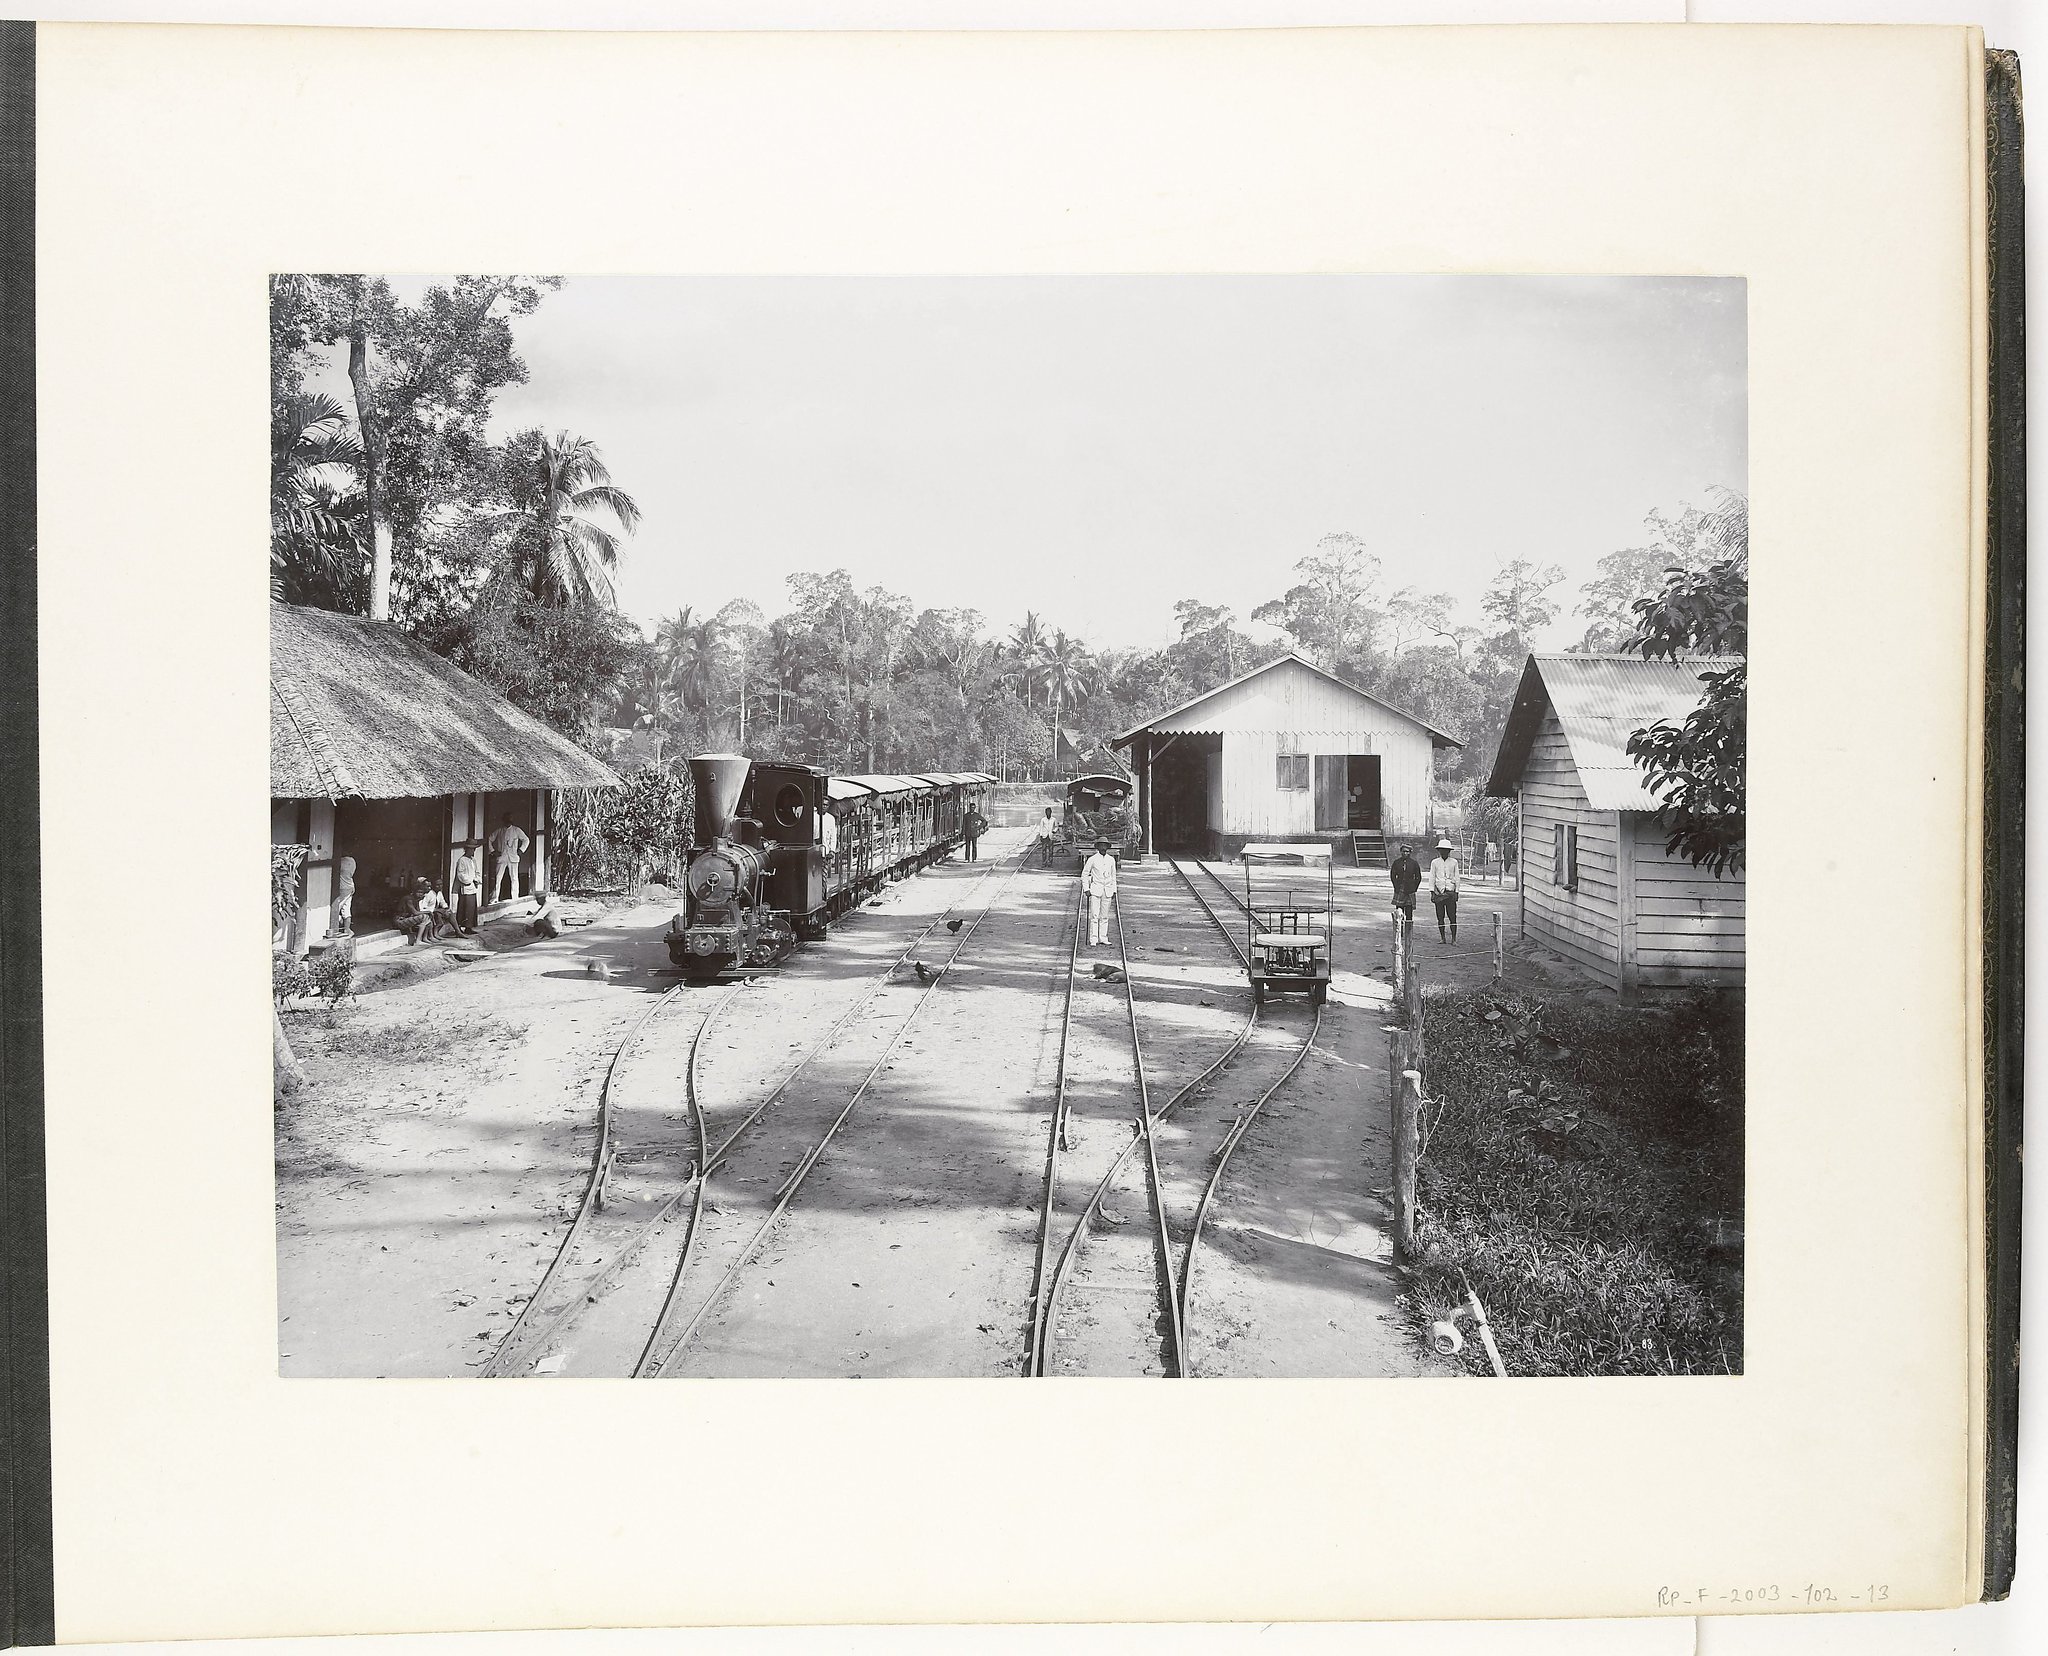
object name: photograph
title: Gezicht op Station Smalspoor van de Deli Maatschappij te Stabat, Sumatra (S.S. Stabat)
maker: carl j. kleingrothe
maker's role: fotograaf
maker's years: 1864-1925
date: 1885-1900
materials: photographic support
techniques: collodion silver print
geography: sumatra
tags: sumatra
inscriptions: number: ‘83.’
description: Gezicht op het emplacement van het smalspoor van de Deli Maatschappij op oliepalm- en rubberonderneming Stabat, onderdeel van Gohor Lama in Langkat in de Oostkust van Sumatra. Onderdeel van het Sumatra fotoalbum van Paul en Lucie Sandel uit 1900.